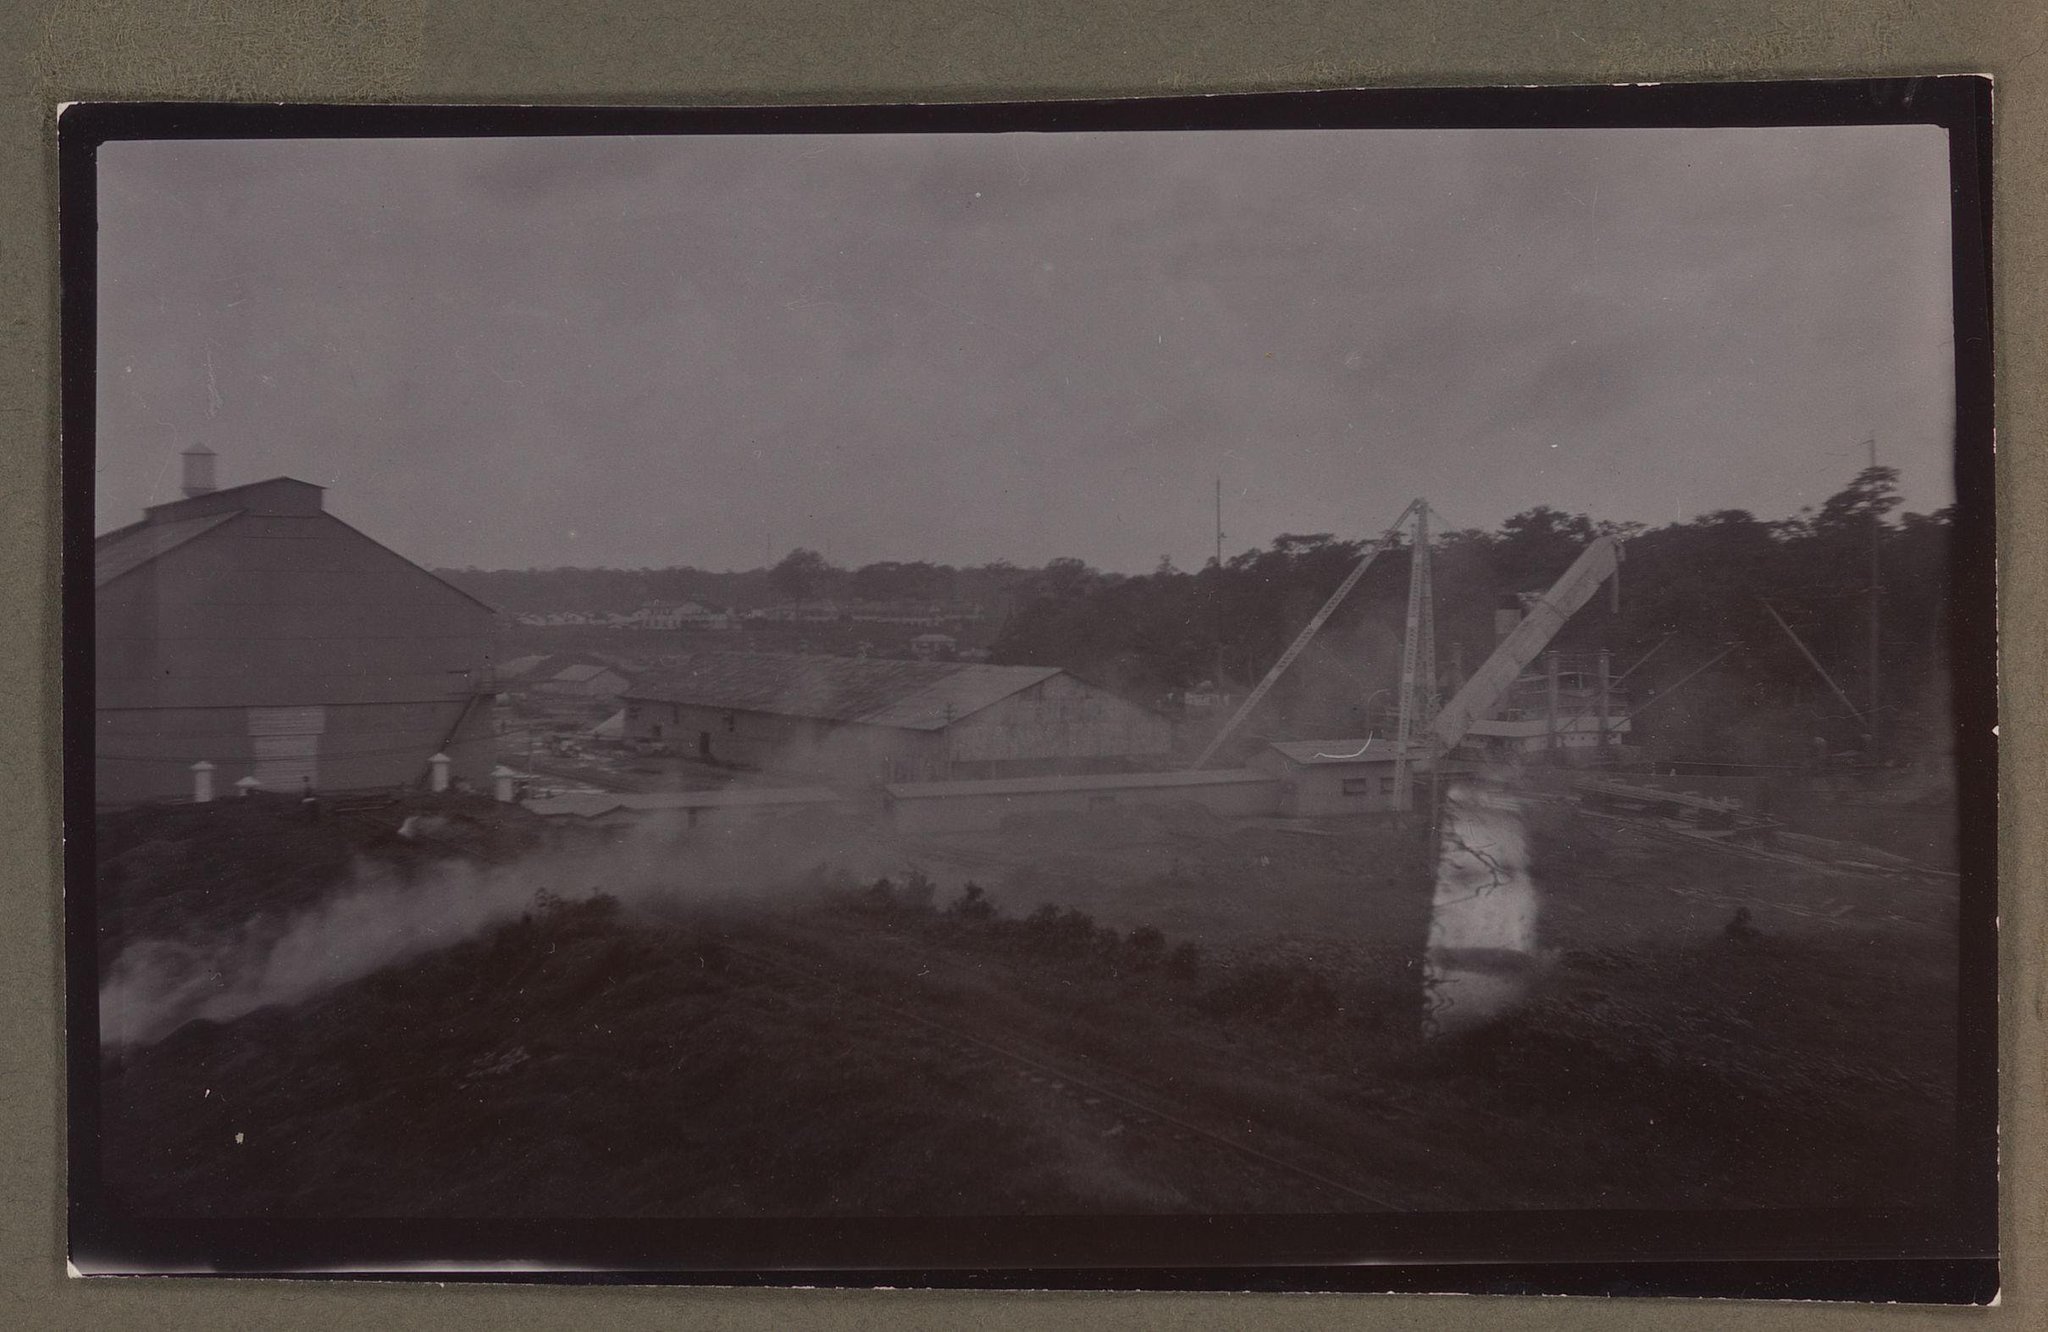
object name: photograph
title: Mijn en fabriek te Moengo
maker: Anonymous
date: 1925-1927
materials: photographic support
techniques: photography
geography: suriname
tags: jetten, familie, moengo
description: Het terrein van de mijn en fabriek te Moengo. Foto op een bladzijde van een los albumblad. Onderdeel van het ensemble met foto's van de familie van ingenieur Jetten in de mijnbouwstad Moengo in Suriname.